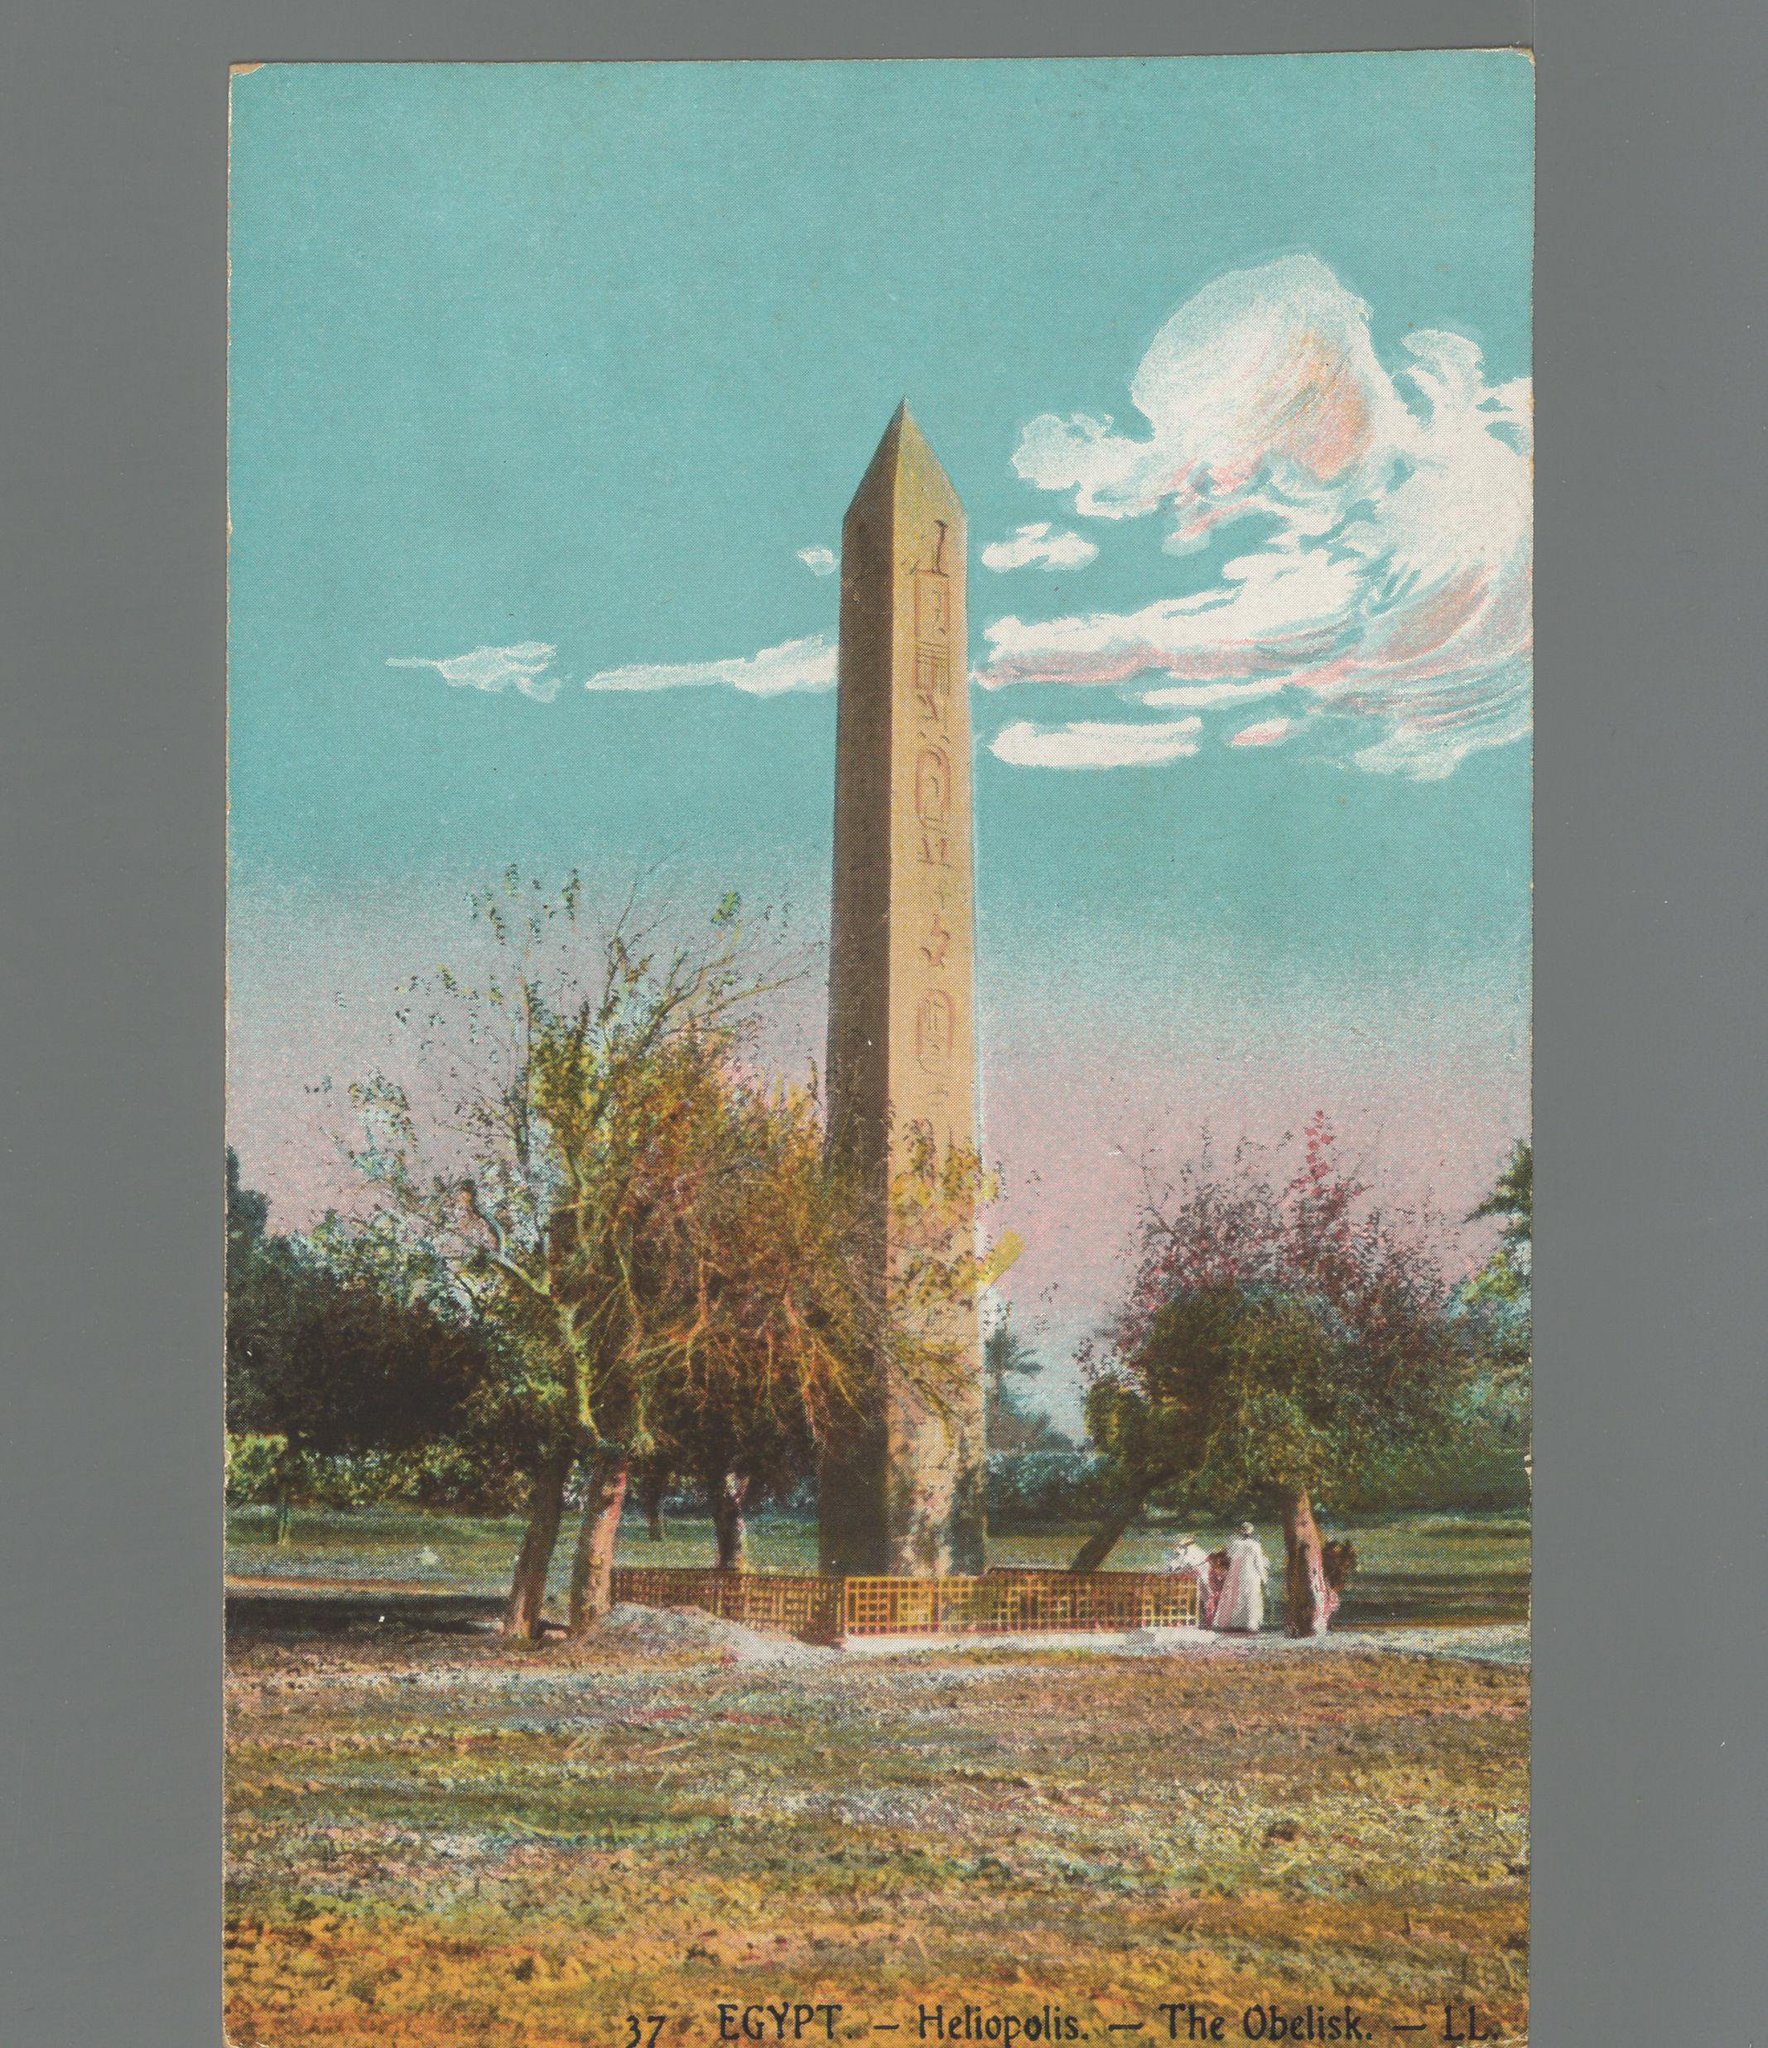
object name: photomechanical print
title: Egypt - Heliopolis - The Obelisk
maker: Anonymous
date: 1907-1930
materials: cardboard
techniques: lithograph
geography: heliopolis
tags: obelisk, needle